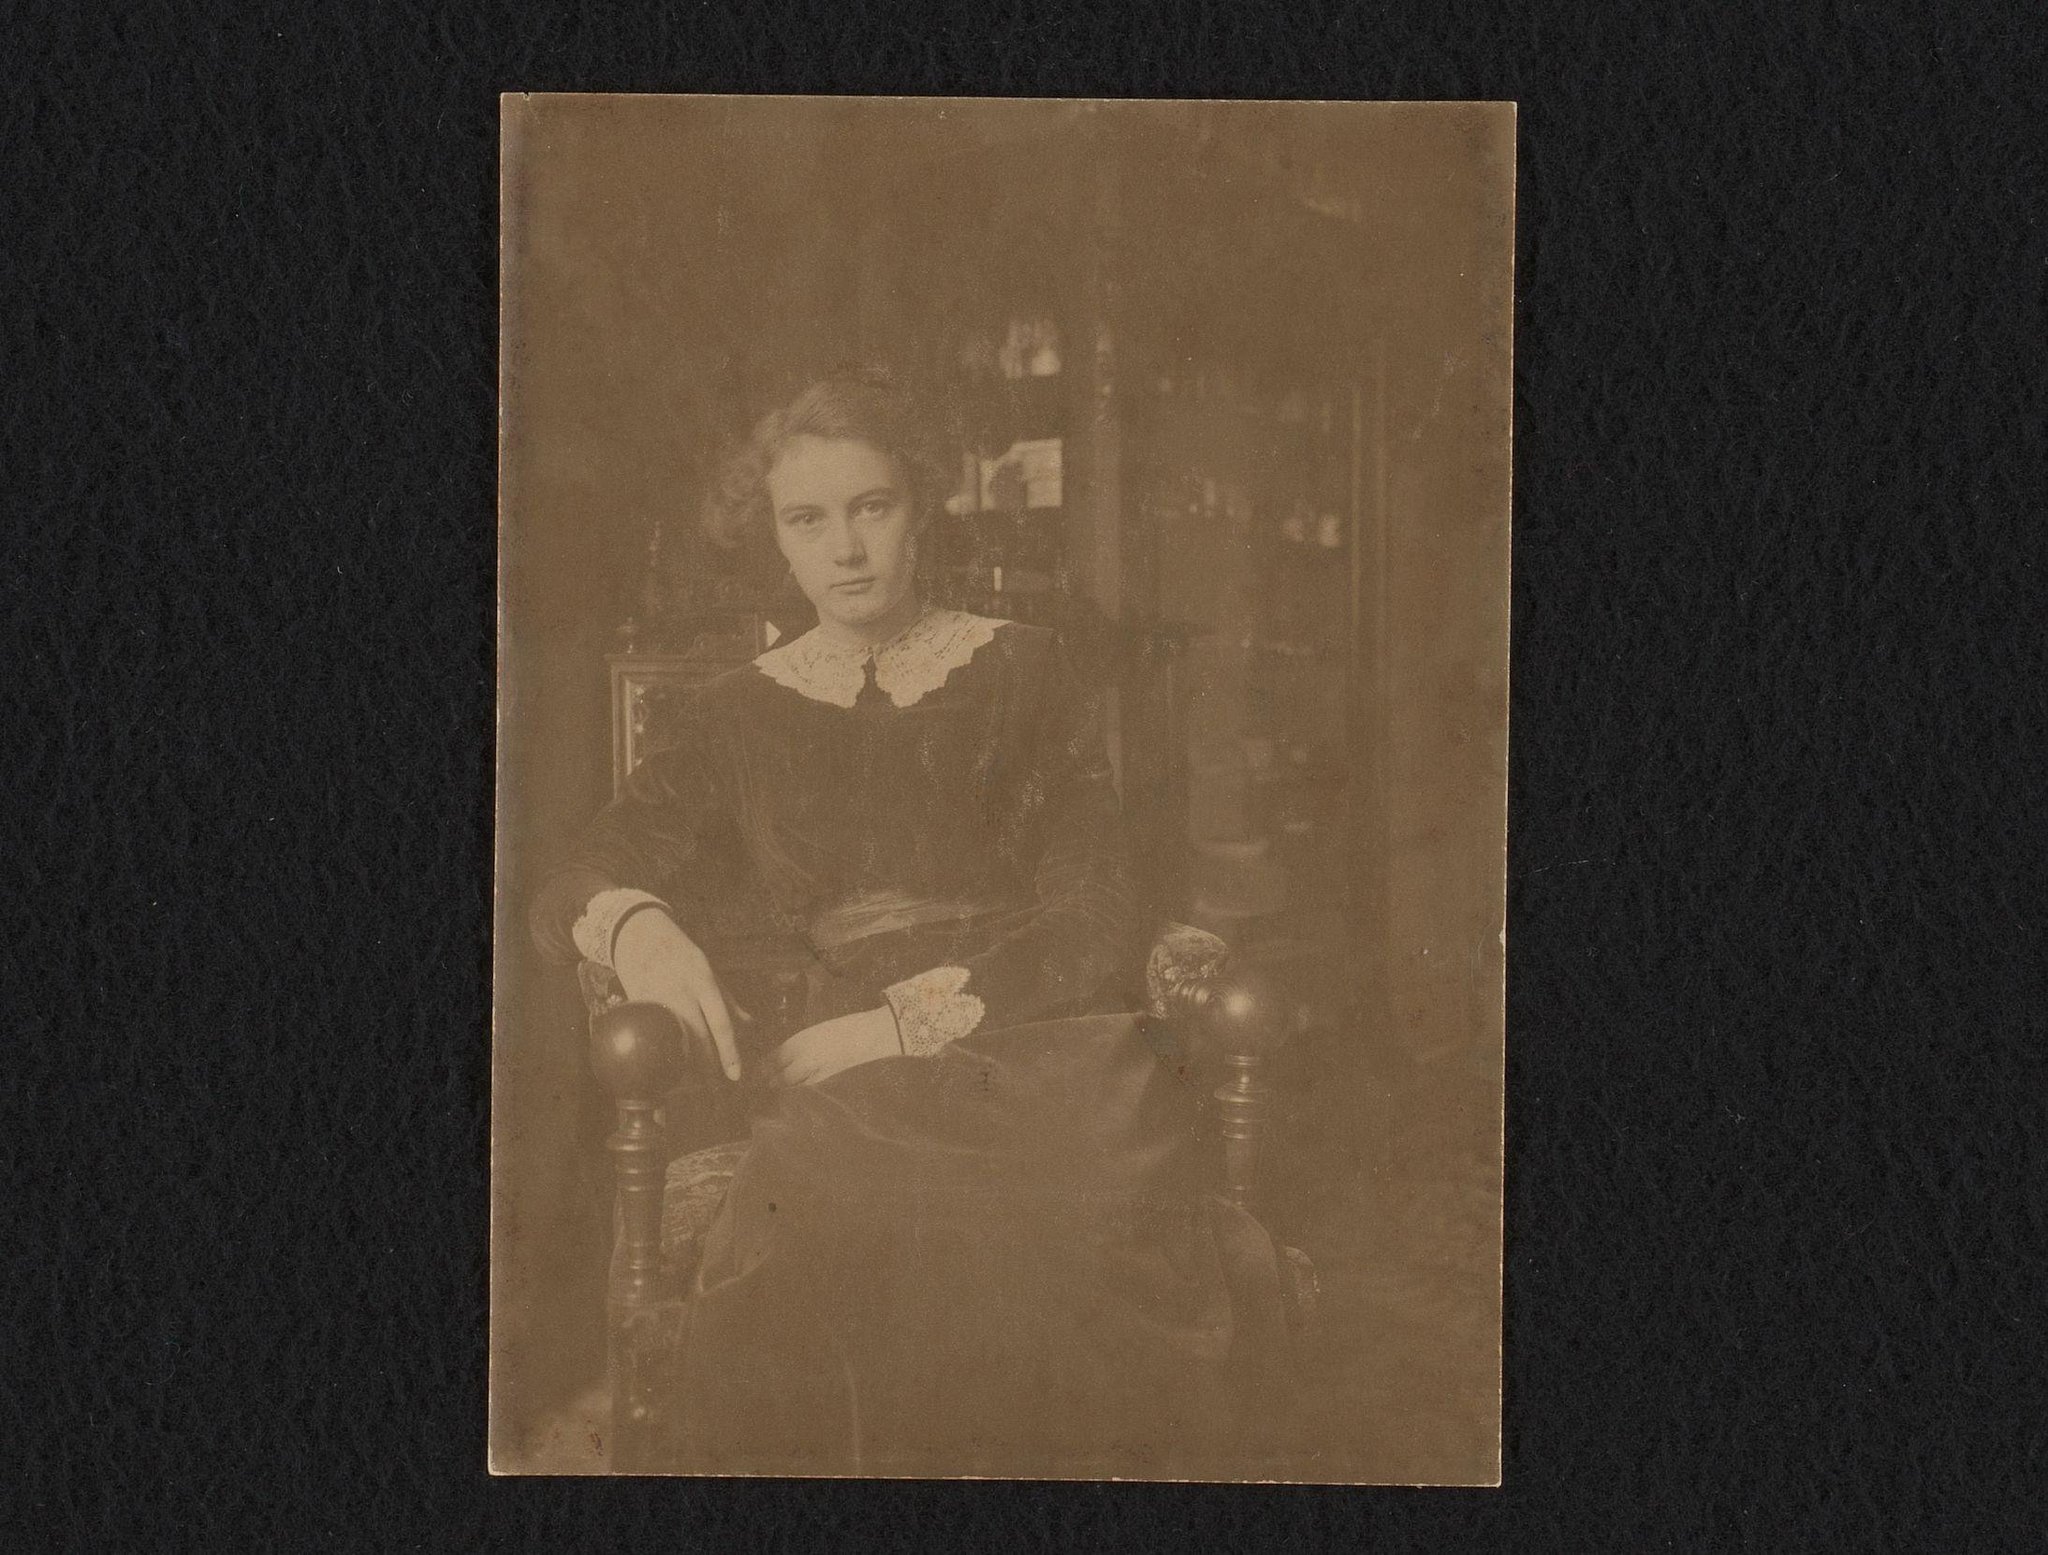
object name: photograph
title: Portret van Johanna (Hans) de Jong op een stoel in een huiskamer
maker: willem de jong (fotograaf)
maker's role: arts, fotograaf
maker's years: 1864-1918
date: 1907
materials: paper, cardboard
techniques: collodion silver print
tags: leiden, johanna petronella lambertina stokhuyzen-de jong (hans), sitting figure, historical persons - bb - woman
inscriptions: inscription: ‘Herp[...]cantie 1907/ (gem. v. Waveren)’